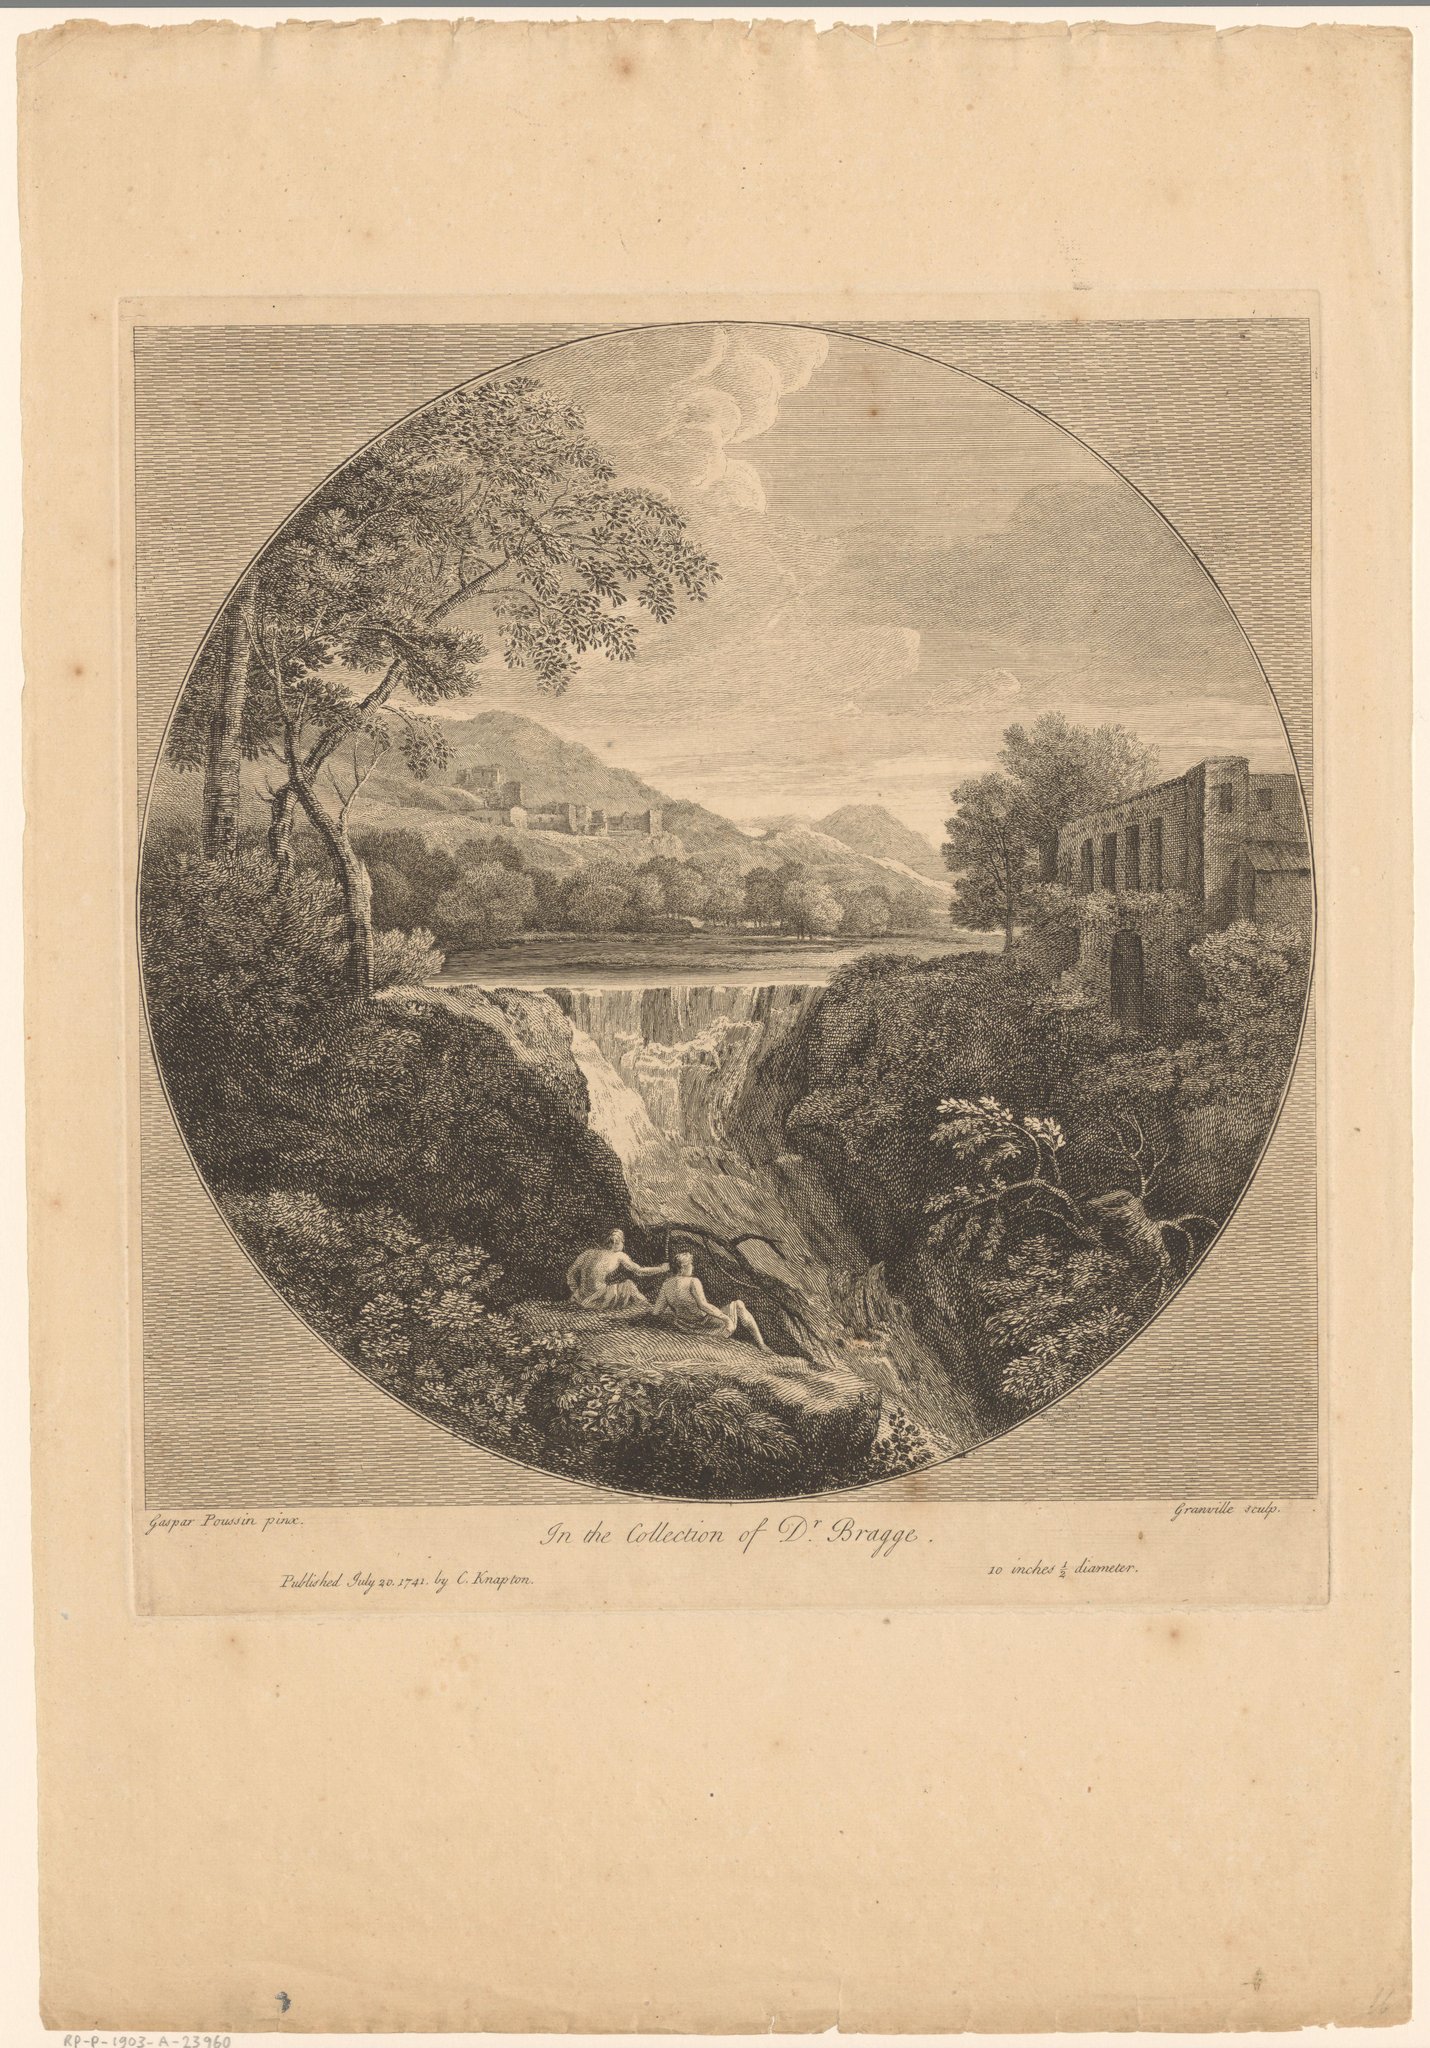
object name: print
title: Italiaanse landschappen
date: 1707-1741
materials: paper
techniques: etching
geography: london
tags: waterfall - hh - ideal landscapes, (high) hill - hh - ideal landscapes, lake - hh - ideal landscapes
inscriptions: collector's mark: Lugt 2228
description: De serie werd tussen 1741 en 1746 door Knapton en Pond uitgegeven.